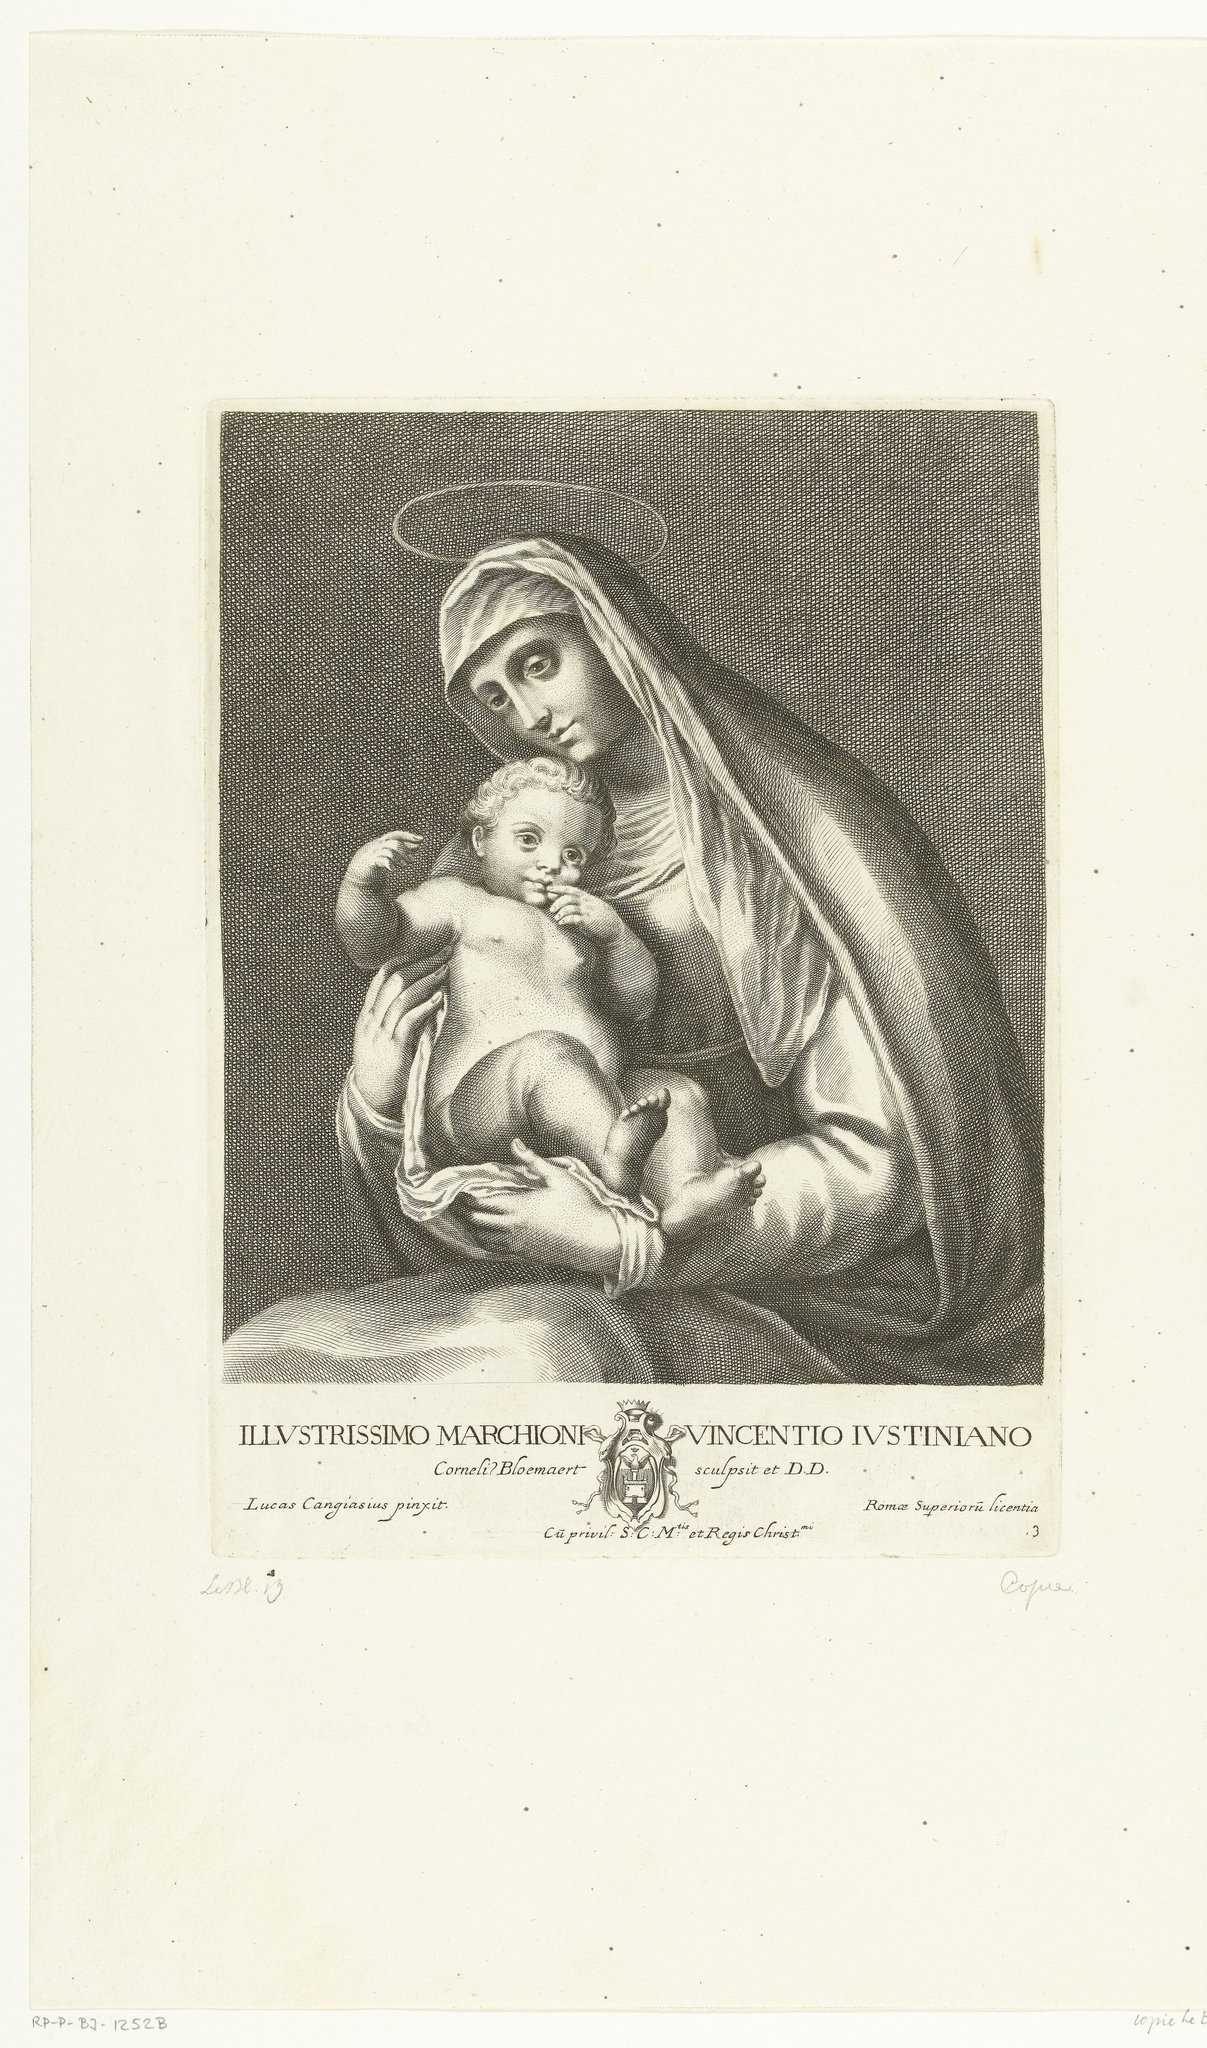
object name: print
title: Zittende Madonna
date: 1636-1637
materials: paper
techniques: engraving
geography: rome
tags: madonna: mary sitting or enthroned, the christ-child in her lap (or in front of her bosom) (mary sometimes represented half-length)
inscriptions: collector's mark: Lugt 2228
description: Maria met aureool, ze draagt het naakte Christuskind op haar schoot.